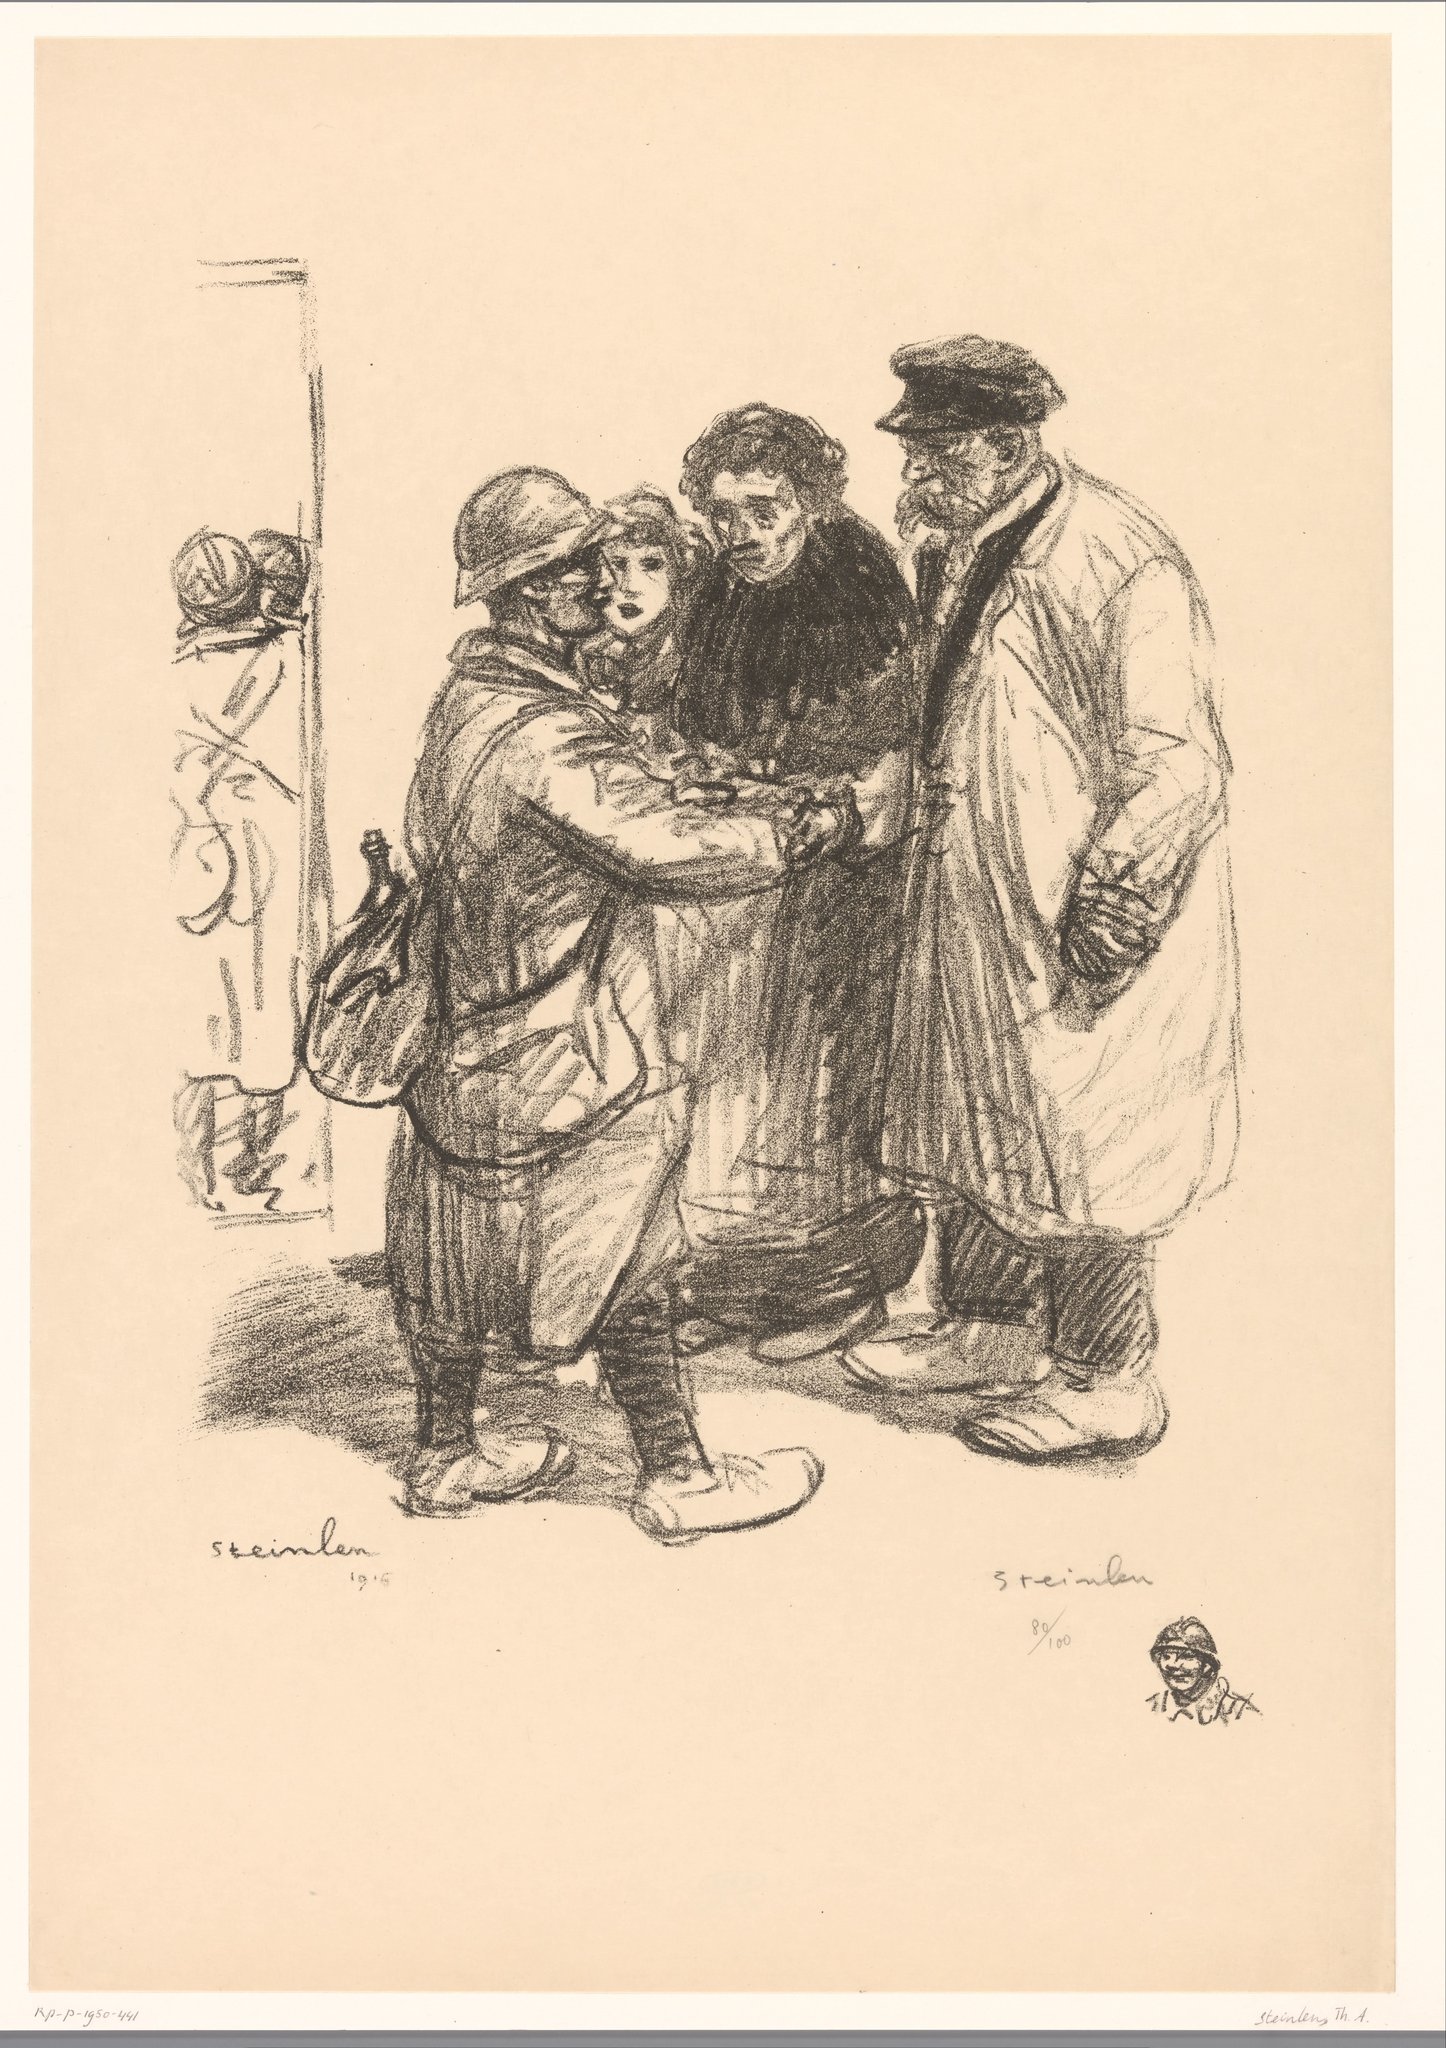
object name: print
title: Soldaat stelt burgers gerust tijdens de Eerste Wereldoorlog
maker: théophile alexandre steinlen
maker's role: draughtsman, painter, print maker, sculptor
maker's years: 1859-1923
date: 1916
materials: paper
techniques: lithograph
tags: the soldier off duty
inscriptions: collector's mark: Lugt 2228, signature: ‘Steinlen’